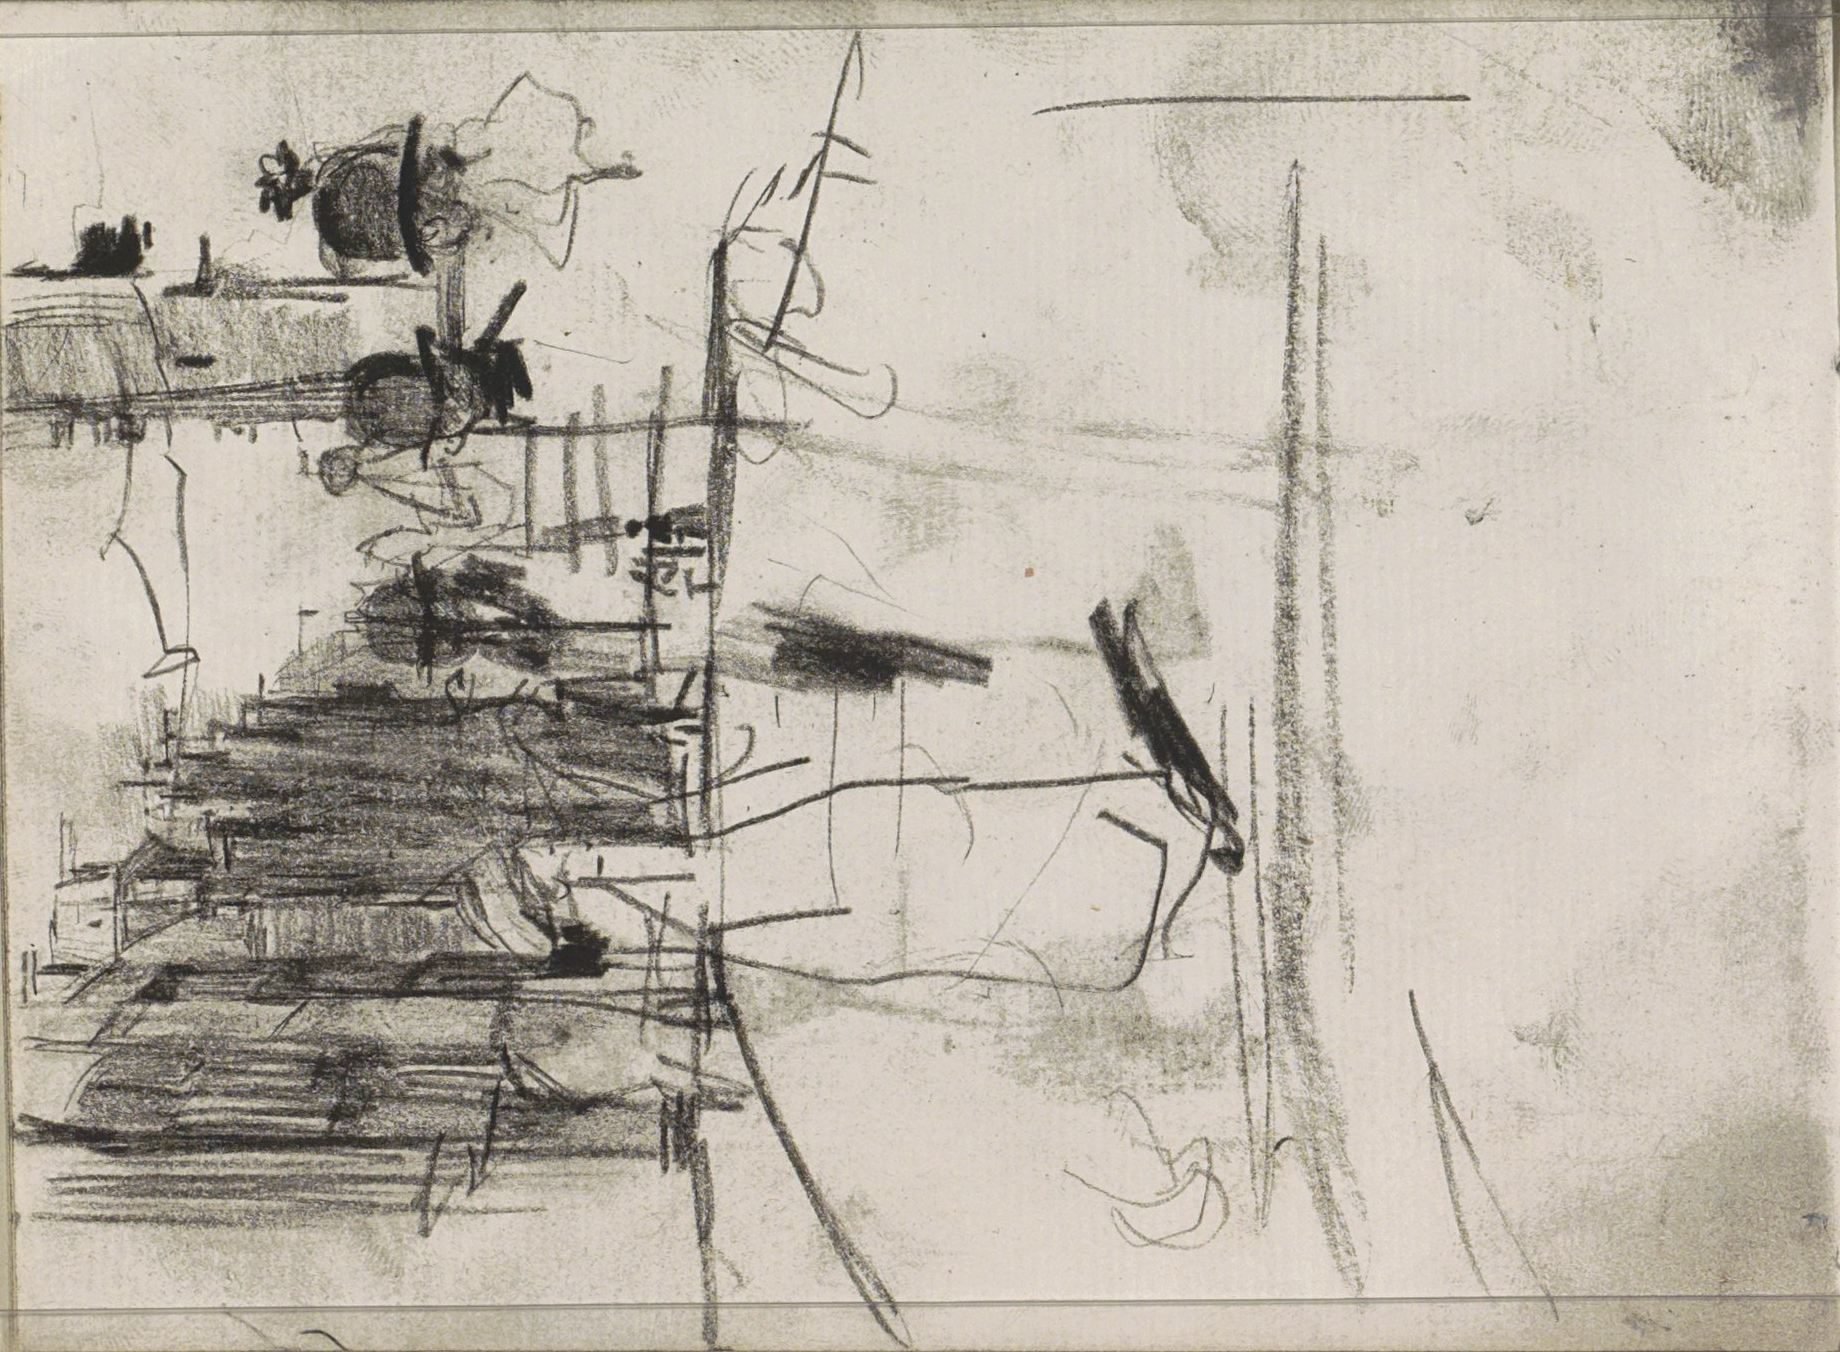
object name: sketchbook leaf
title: Figuren op straat, mogelijk in Amsterdam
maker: isaac israels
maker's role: draughtsman, painter, print maker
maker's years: 1865-1934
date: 1886-1903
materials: chalk, paper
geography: amsterdam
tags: street (+ city(-scape) with figures, staffage), amsterdam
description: Onder andere mannen met bolhoeden. Pagina 34 uit schetsboek XLVII met 52 pagina's.